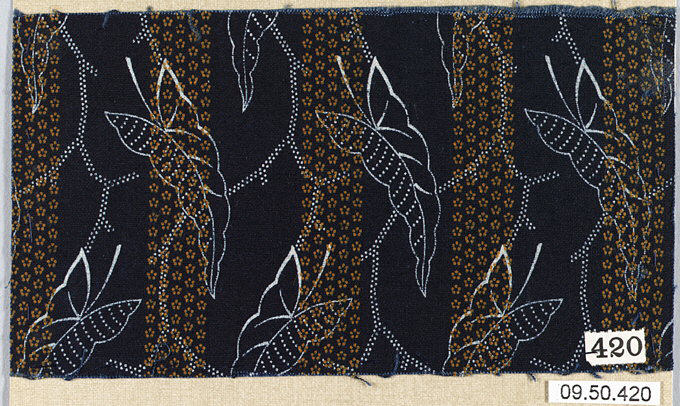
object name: piece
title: Piece (one of 116)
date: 1801-1900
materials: cotton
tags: leaves